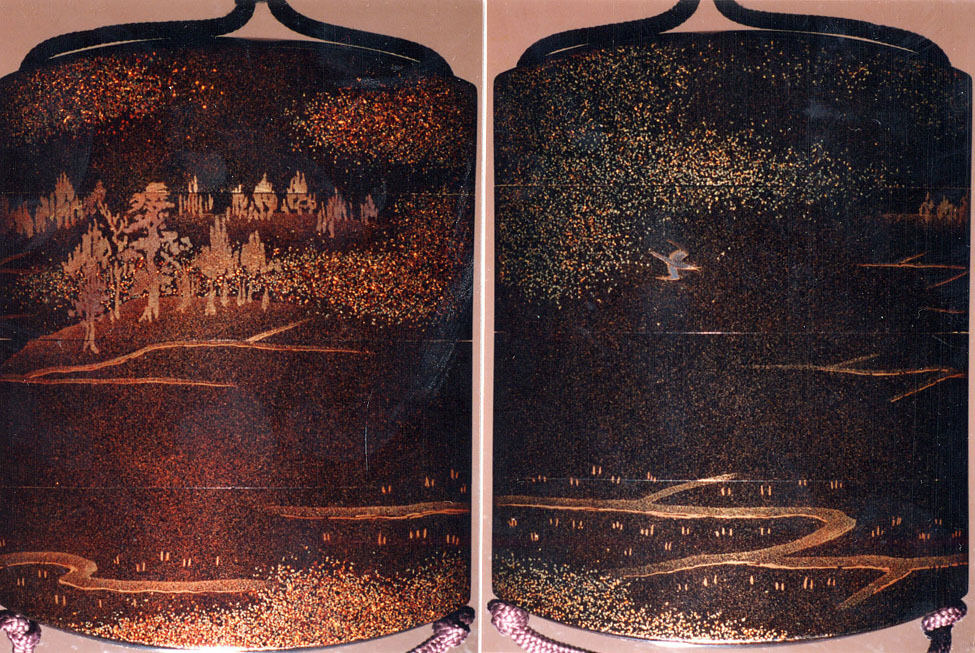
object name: inrō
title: Case (Inrō) with Design of Bird in Flight above Rice Fields (obverse); Trees and Clouds (reverse)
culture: japanese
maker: hogen eisen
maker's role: artist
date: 1801-1900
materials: gold, lacquer, silver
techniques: fundame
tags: birds,trees